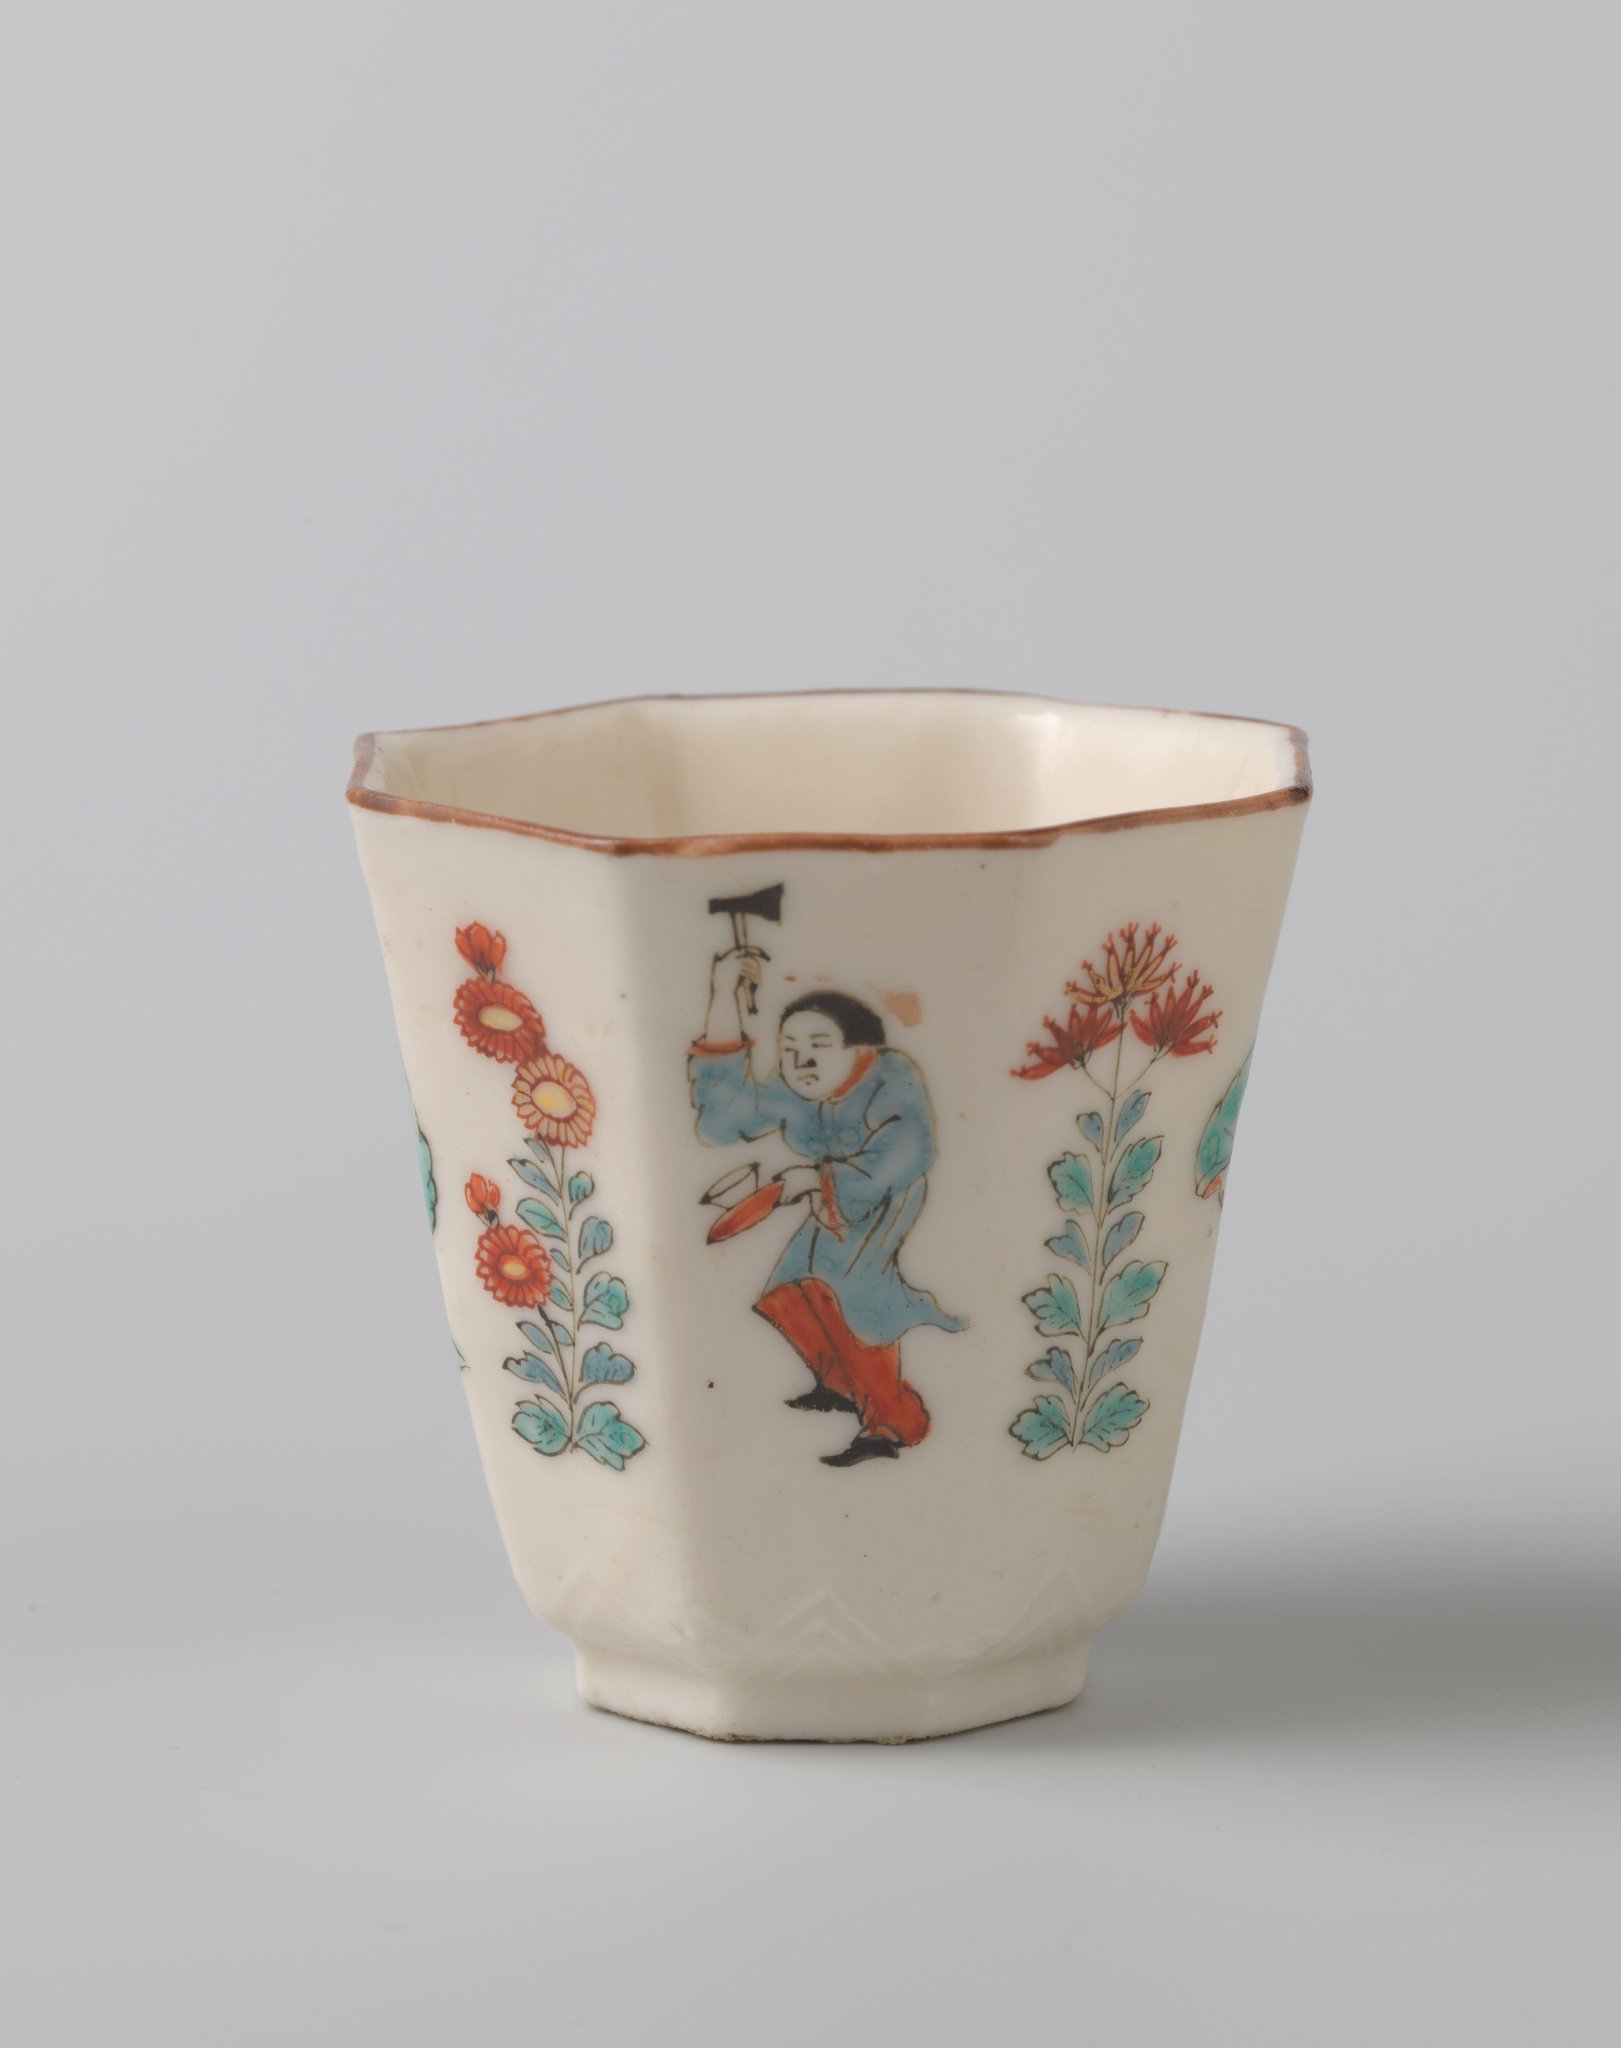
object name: bowl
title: Octagonal cup with dancing boys and flowering plants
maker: Anonymous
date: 1700-1720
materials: glaze, gold, paint, porcelain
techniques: firing, forming, gilding, turning, vitrification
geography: europe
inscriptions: mark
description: AK-NM-6402 Zes koppen • Gekleurd porselein – gedecoreerd in Nederland • Onderdeel van Royers porseleincollectie Dit zijn blanc de Chine kopjes die in Nederland zijn beschilderd. Zie hiervoor ook de toelichting bij de flessen AK-NM-6464. Waarschijnlijk zijn afkomstig uit de collectie van Royers oudtante Susanna Louise Huygens (1714-1785). Royer kocht voor een groot bedrag uit haar nalatenschap, en omdat nergens gespecificeerd is welke stukken dat waren, is een vergelijking van de beschrijvingen in Susanna Louises boedel en Royers voorwerpen, de beste manier om de Huygens-herkomst aannemelijk te maken. In de boedel vinden we bij het gekleurde porselein: ‘Ses achtkantige kandeelkoppen, met Chineesche figuuren, bloemwerk, bruine rand.’ Ik vind dit een vrij overtuigende match. Tot mijn spijt is het niet gelukt een voorbeeld te vinden dat de Nederlandse porseleinschilder gebruikte voor de musicerende mannetjes. Het is niet te vinden bij Pieter Schenks Chinese en Vremden Nasie of Nieuw Geinventeerde Sineesen en niet in de Schulz codex uit Meissen [Rudi 2010]. Blanc de Chine werd met enige regelmaat in Nederland en elders beschilderd. Er zijn dan ook vrij veel voorbeelden te vinden van vergelijkbare (hoewel niet identieke) kopjes [Ayers 1990, nr. 270; Krahl & Harrison-Hall 1994, nr. 149, Espir 2005, p. 212, afb. 10]. Bronnen: John Ayers, Porcelain for palaces: the fashion for Japan in Europe 1650-1750 (tent.cat. British Museum), Z.pl., 1990. Regina Krahl and Jessica Harrison-Hall, Ancient Chinese trade ceramics from the British Museum, London, Taipei, 1994. Helen Espir, European decoration on oriental porcelain 1700-1830, Londen, 2005. Thomas Rudi (red.), Exotische Welten: der Schulz-Codex und das frühe Meissener Porzellan, Leipzig, 2010.